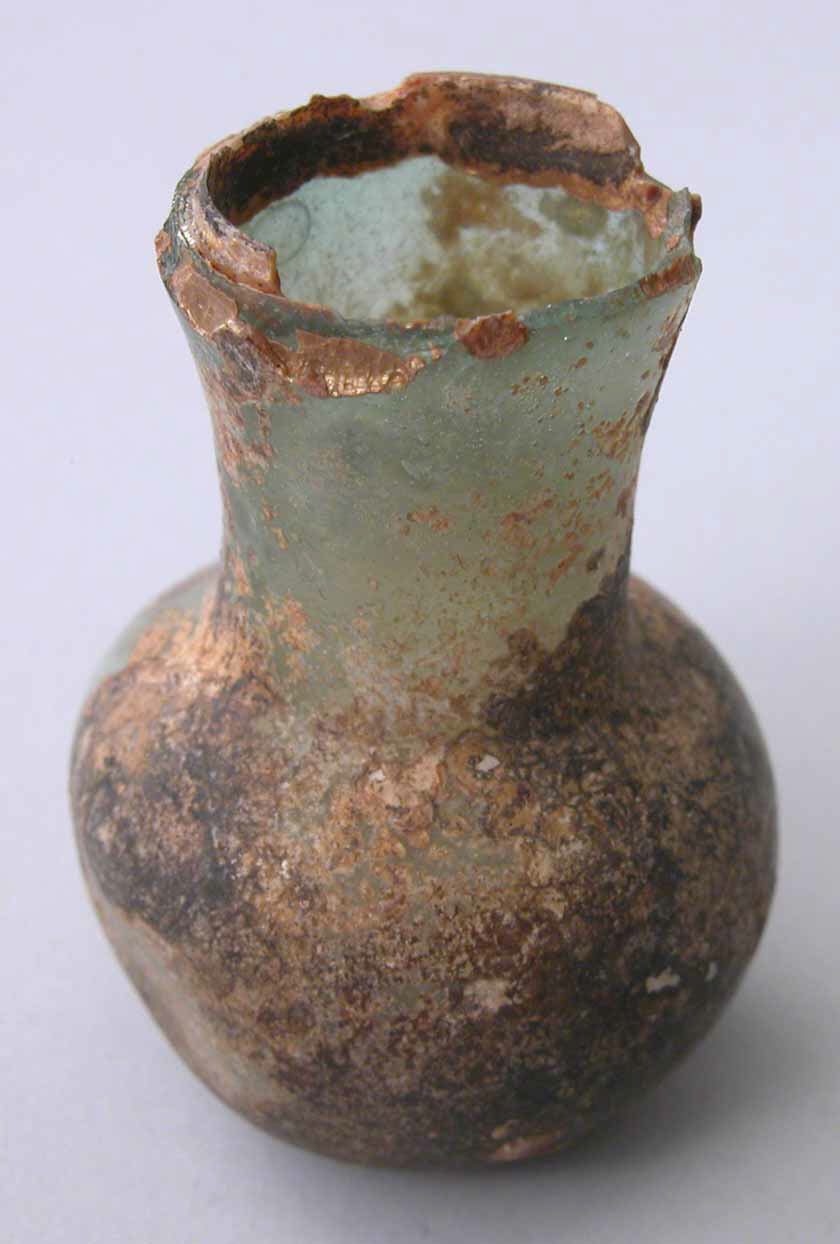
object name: bottle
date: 901-1100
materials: glass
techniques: glassblowing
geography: iran